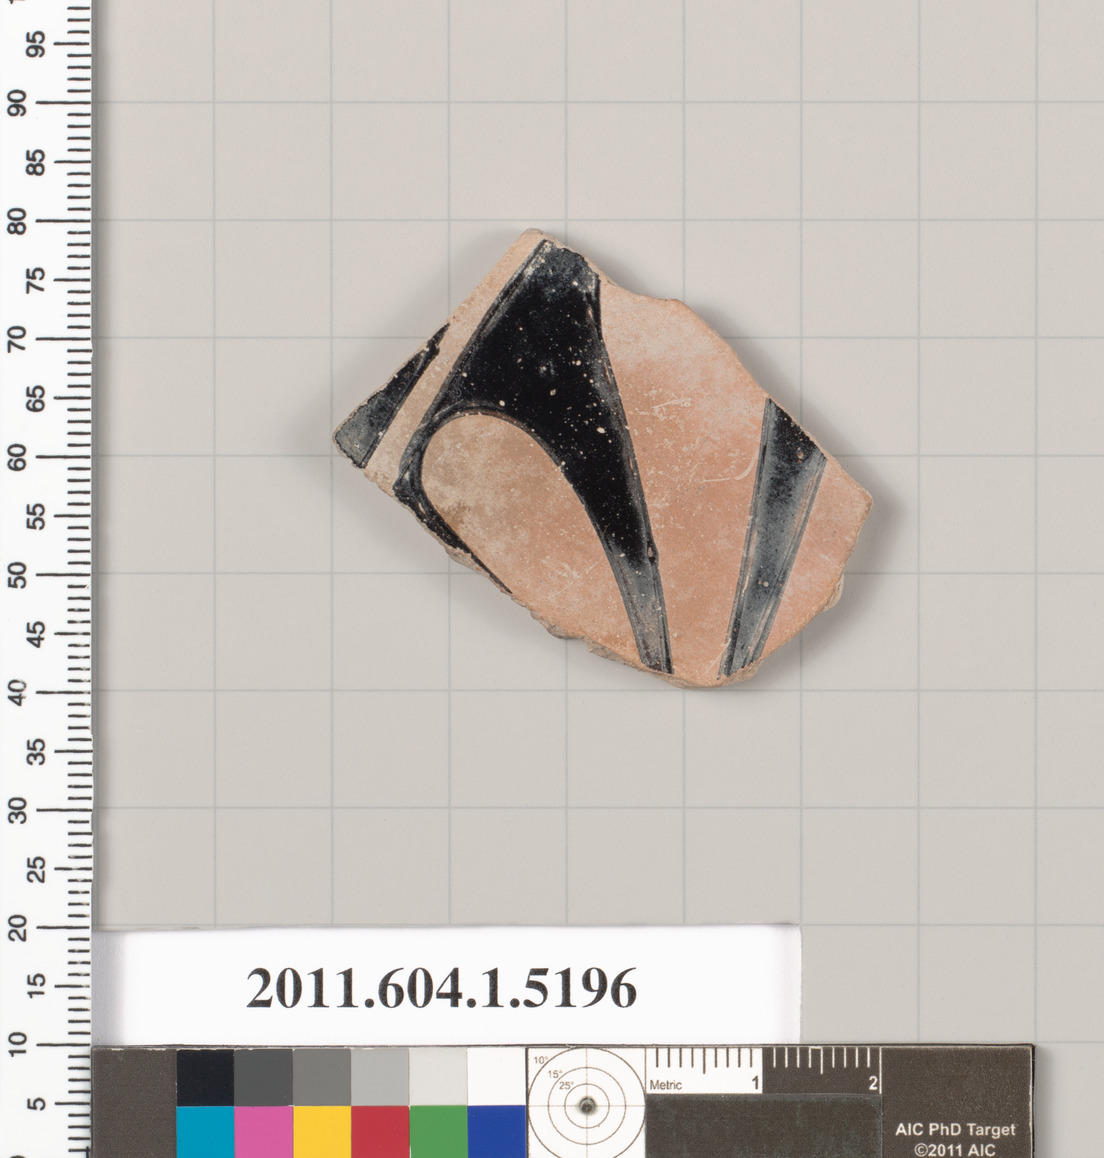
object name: kylix fragment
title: Terracotta fragment of a kylix (drinking cup)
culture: greek, attic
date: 520-510 BCE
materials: terracotta